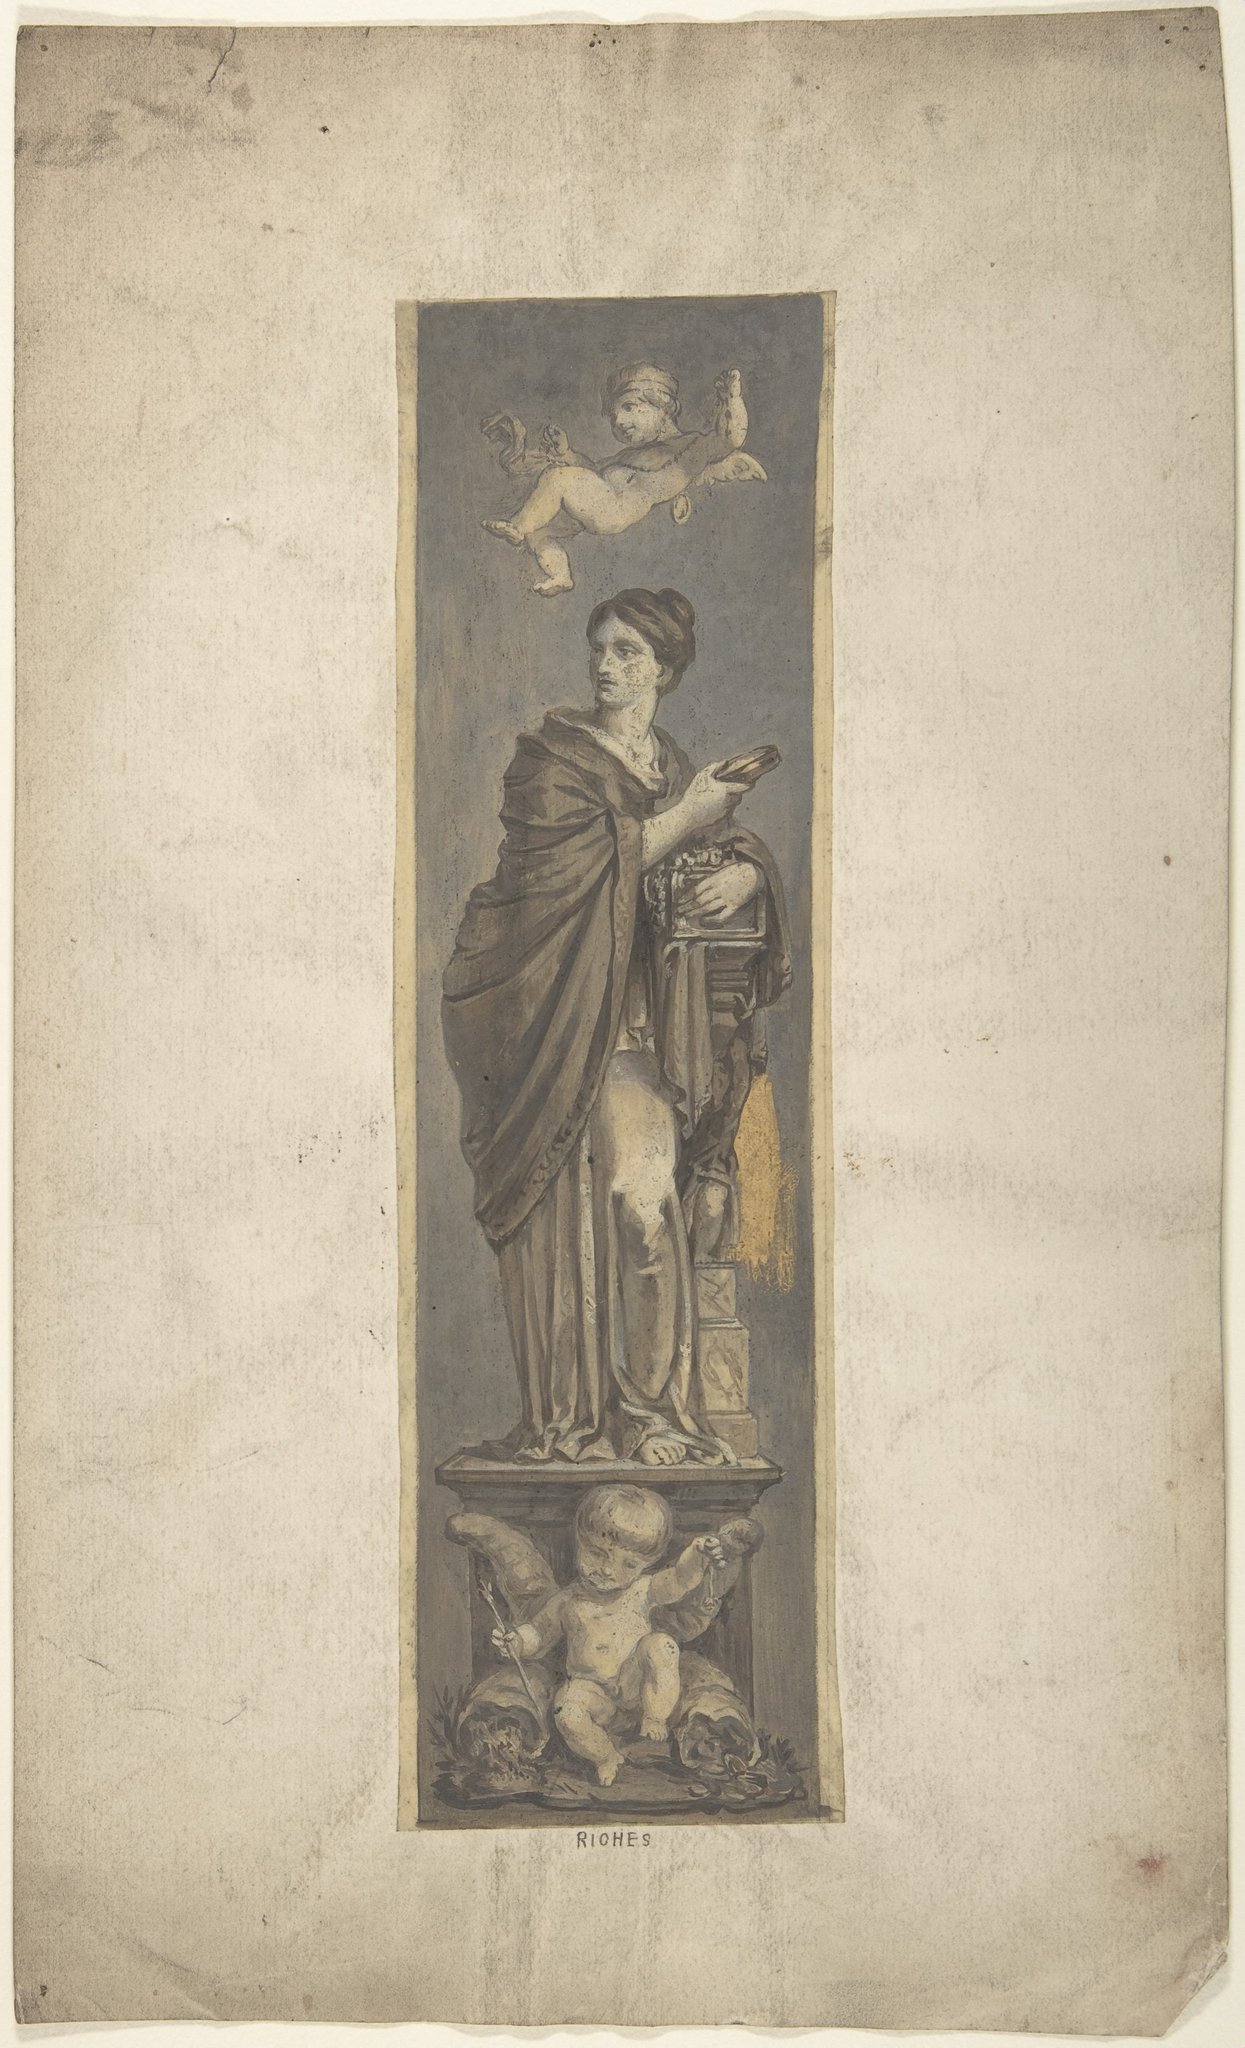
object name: drawing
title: Wall Decoration with Allegorical Figure of Riches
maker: anonymous, british, 19th century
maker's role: artist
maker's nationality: british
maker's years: 1800-1900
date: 1801-1900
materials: gouache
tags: women,cupid